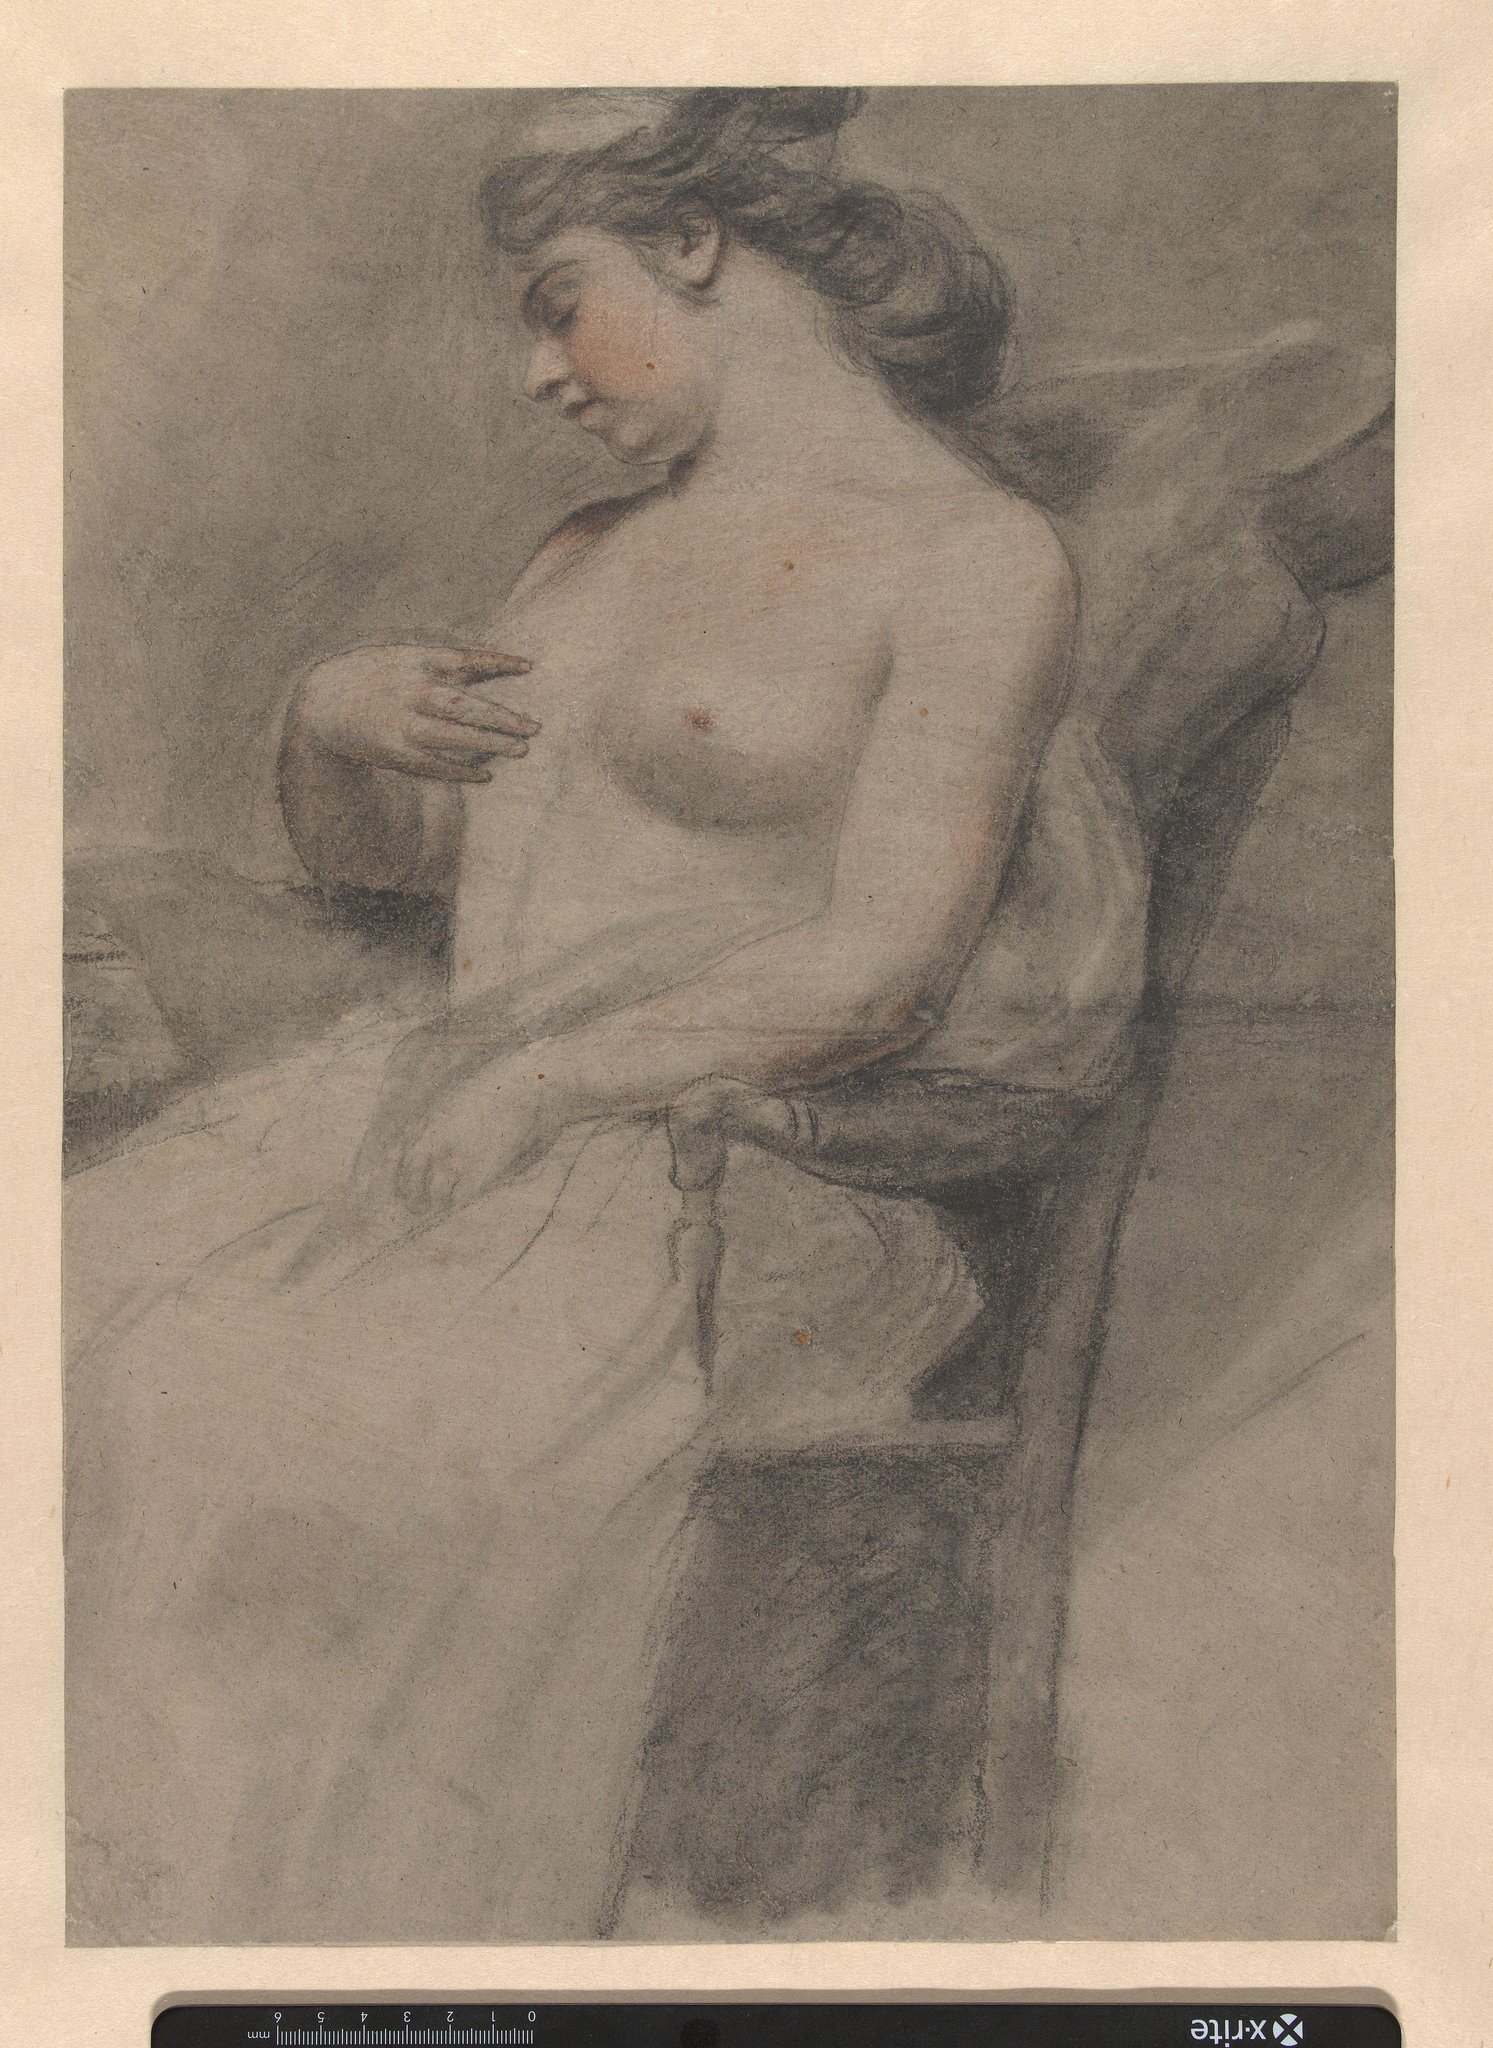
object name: drawing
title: Zittende naakte vrouw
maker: Anonymous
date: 1700-1800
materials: chalk, paper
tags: chinese, coast